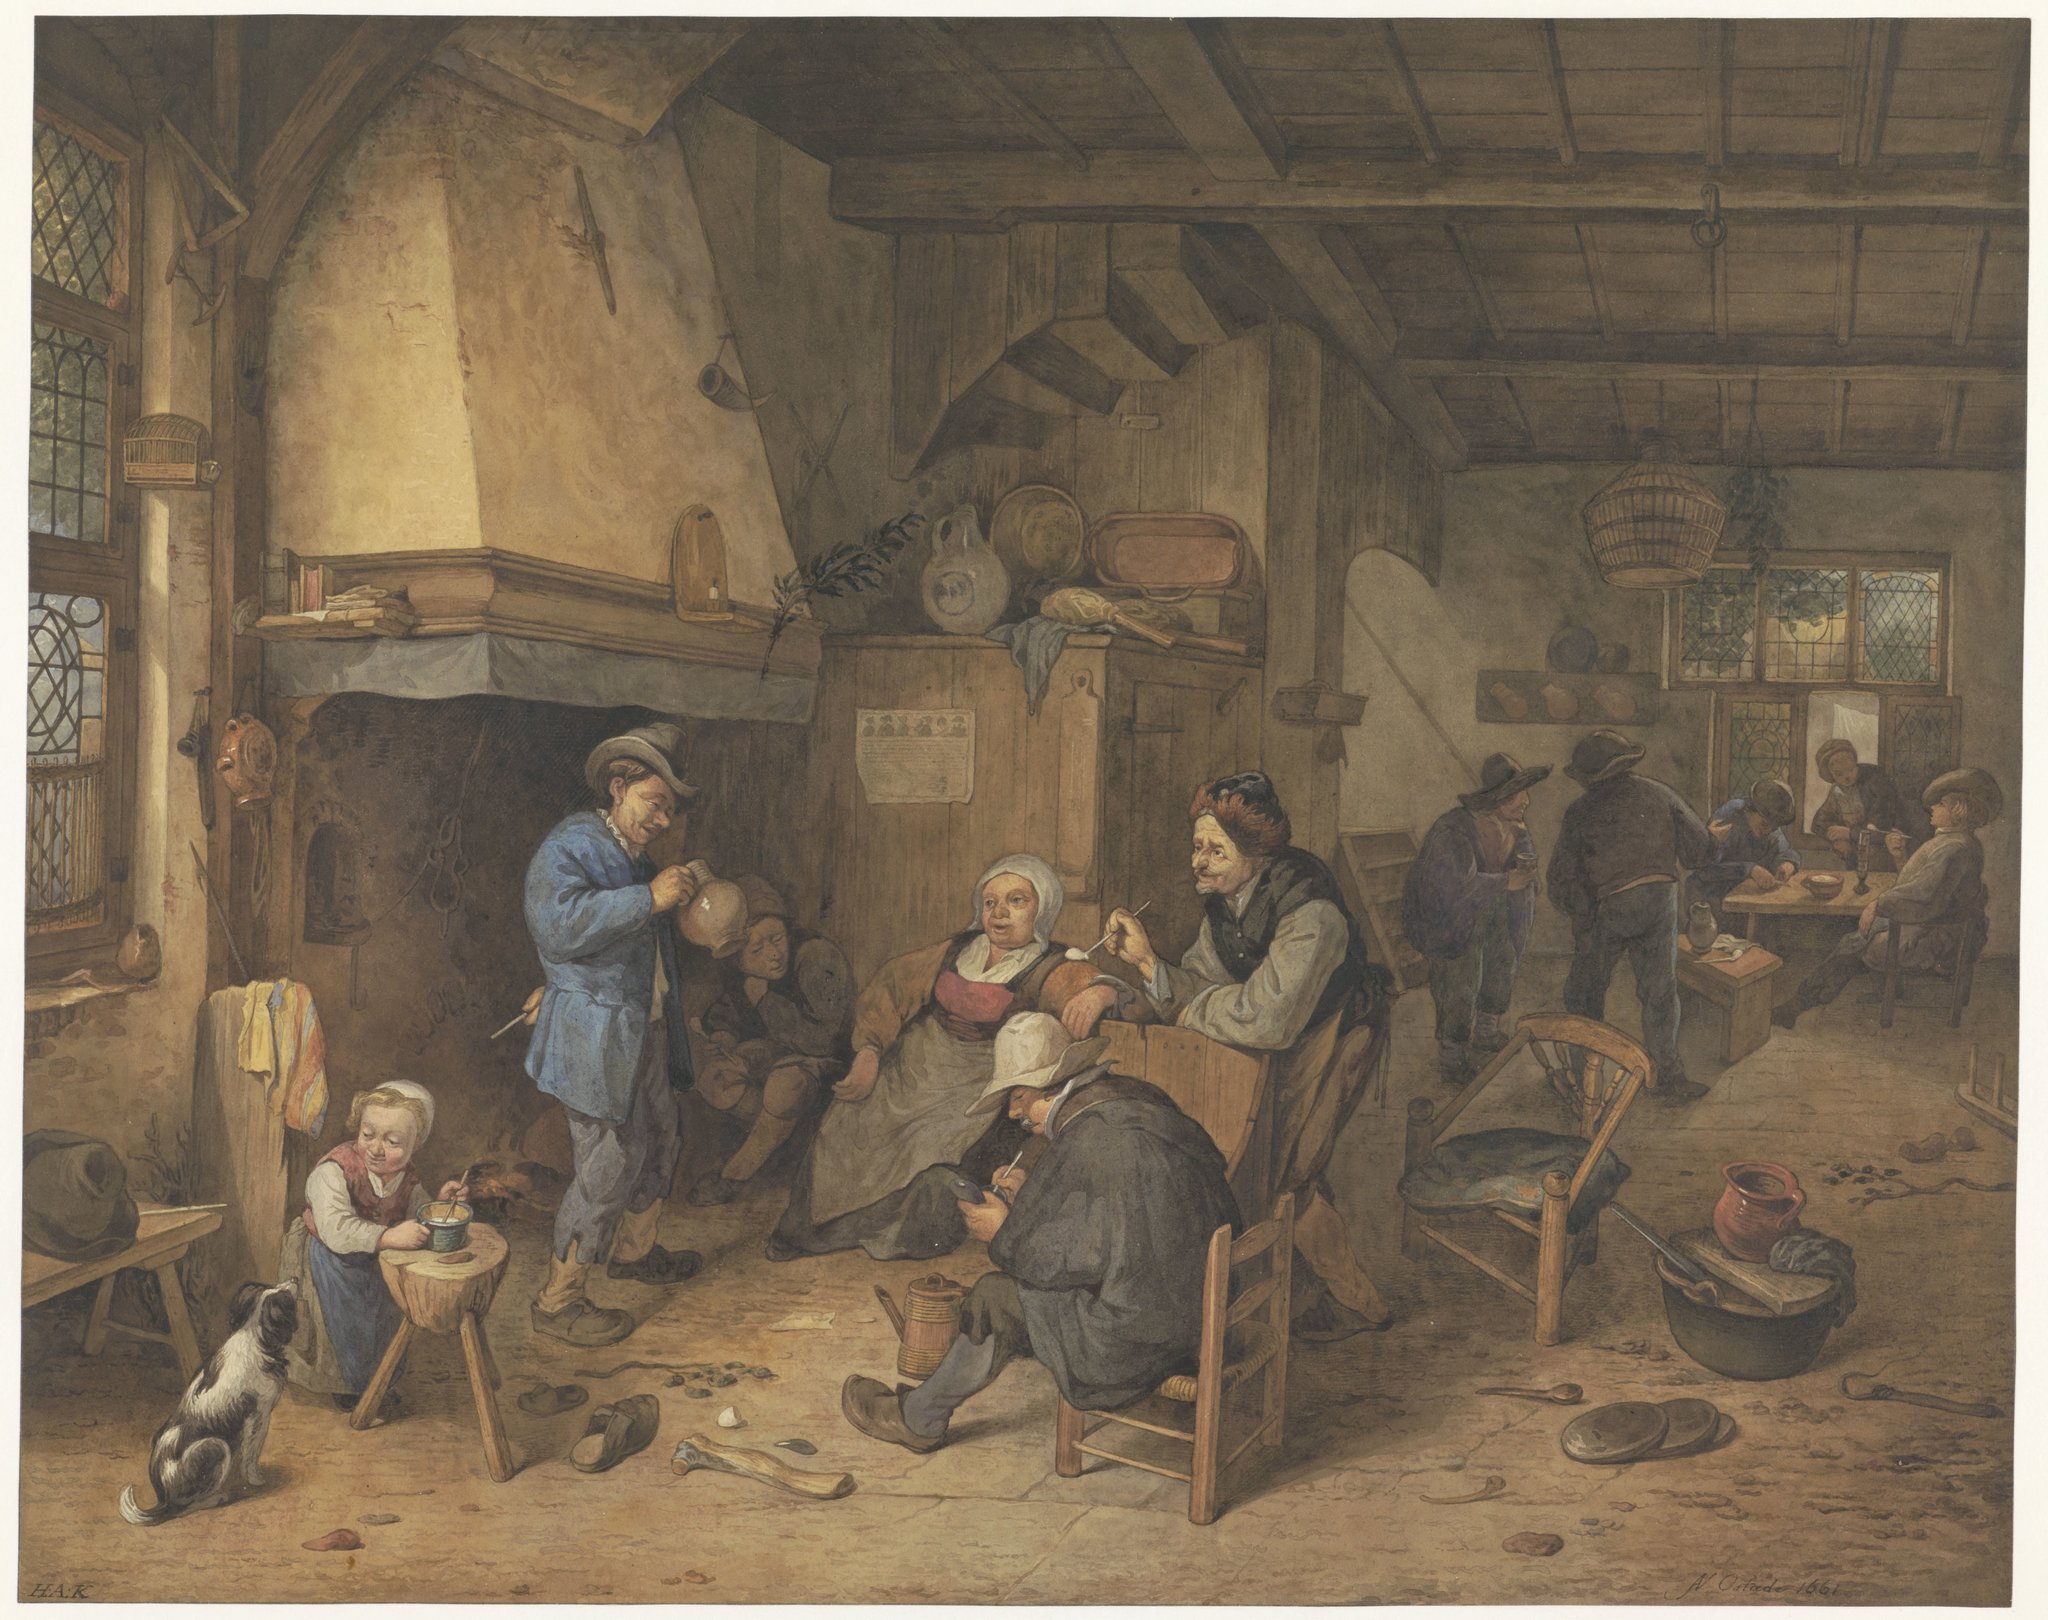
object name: watercolor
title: Boerengezelschap binnenshuis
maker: hendrik abraham klinkhamer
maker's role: draughtsman, painter, print maker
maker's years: 1810-1872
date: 1868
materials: paint, paper, watercolor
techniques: brush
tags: interior of the house, farm (building)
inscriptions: date: ‘1868’